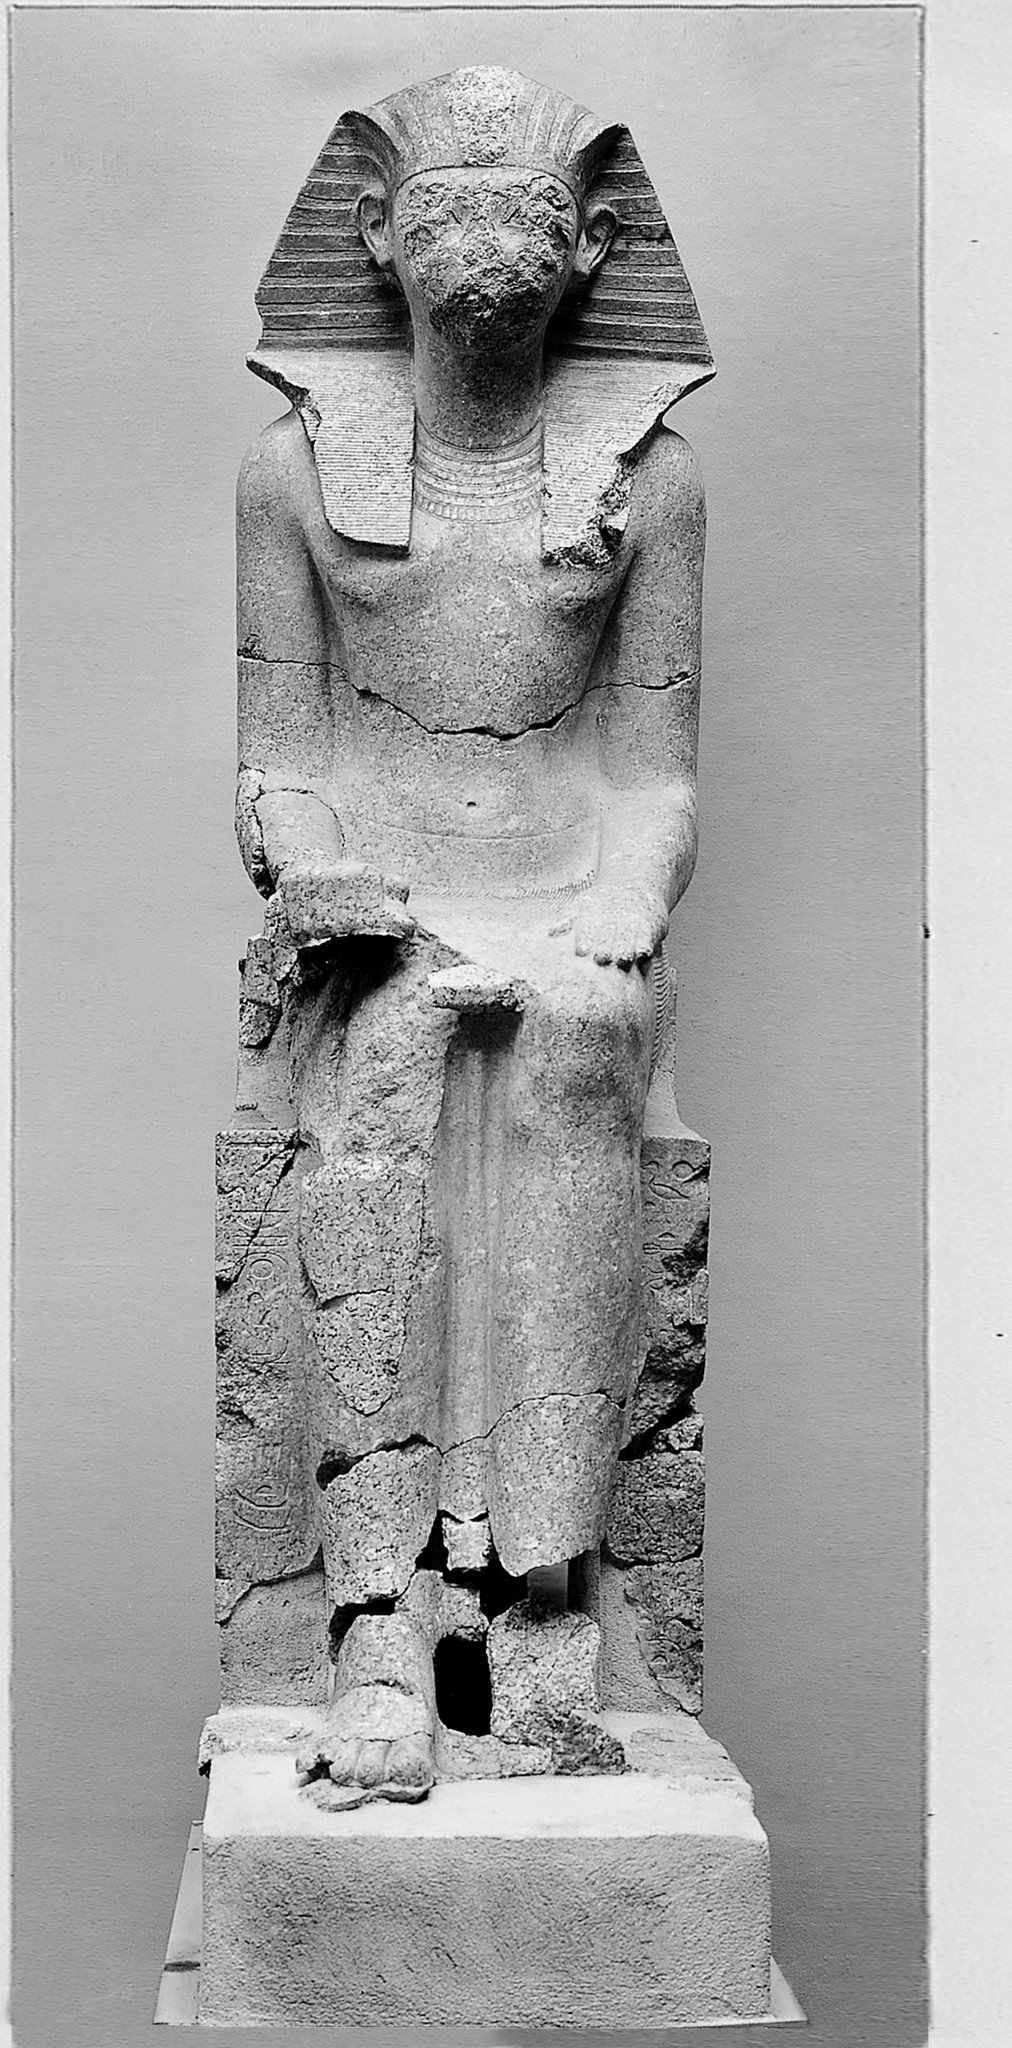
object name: statue, hatshepsut seated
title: Large Seated Statue of Hatshepsut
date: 1479-1458 BCE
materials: granite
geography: egypt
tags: men